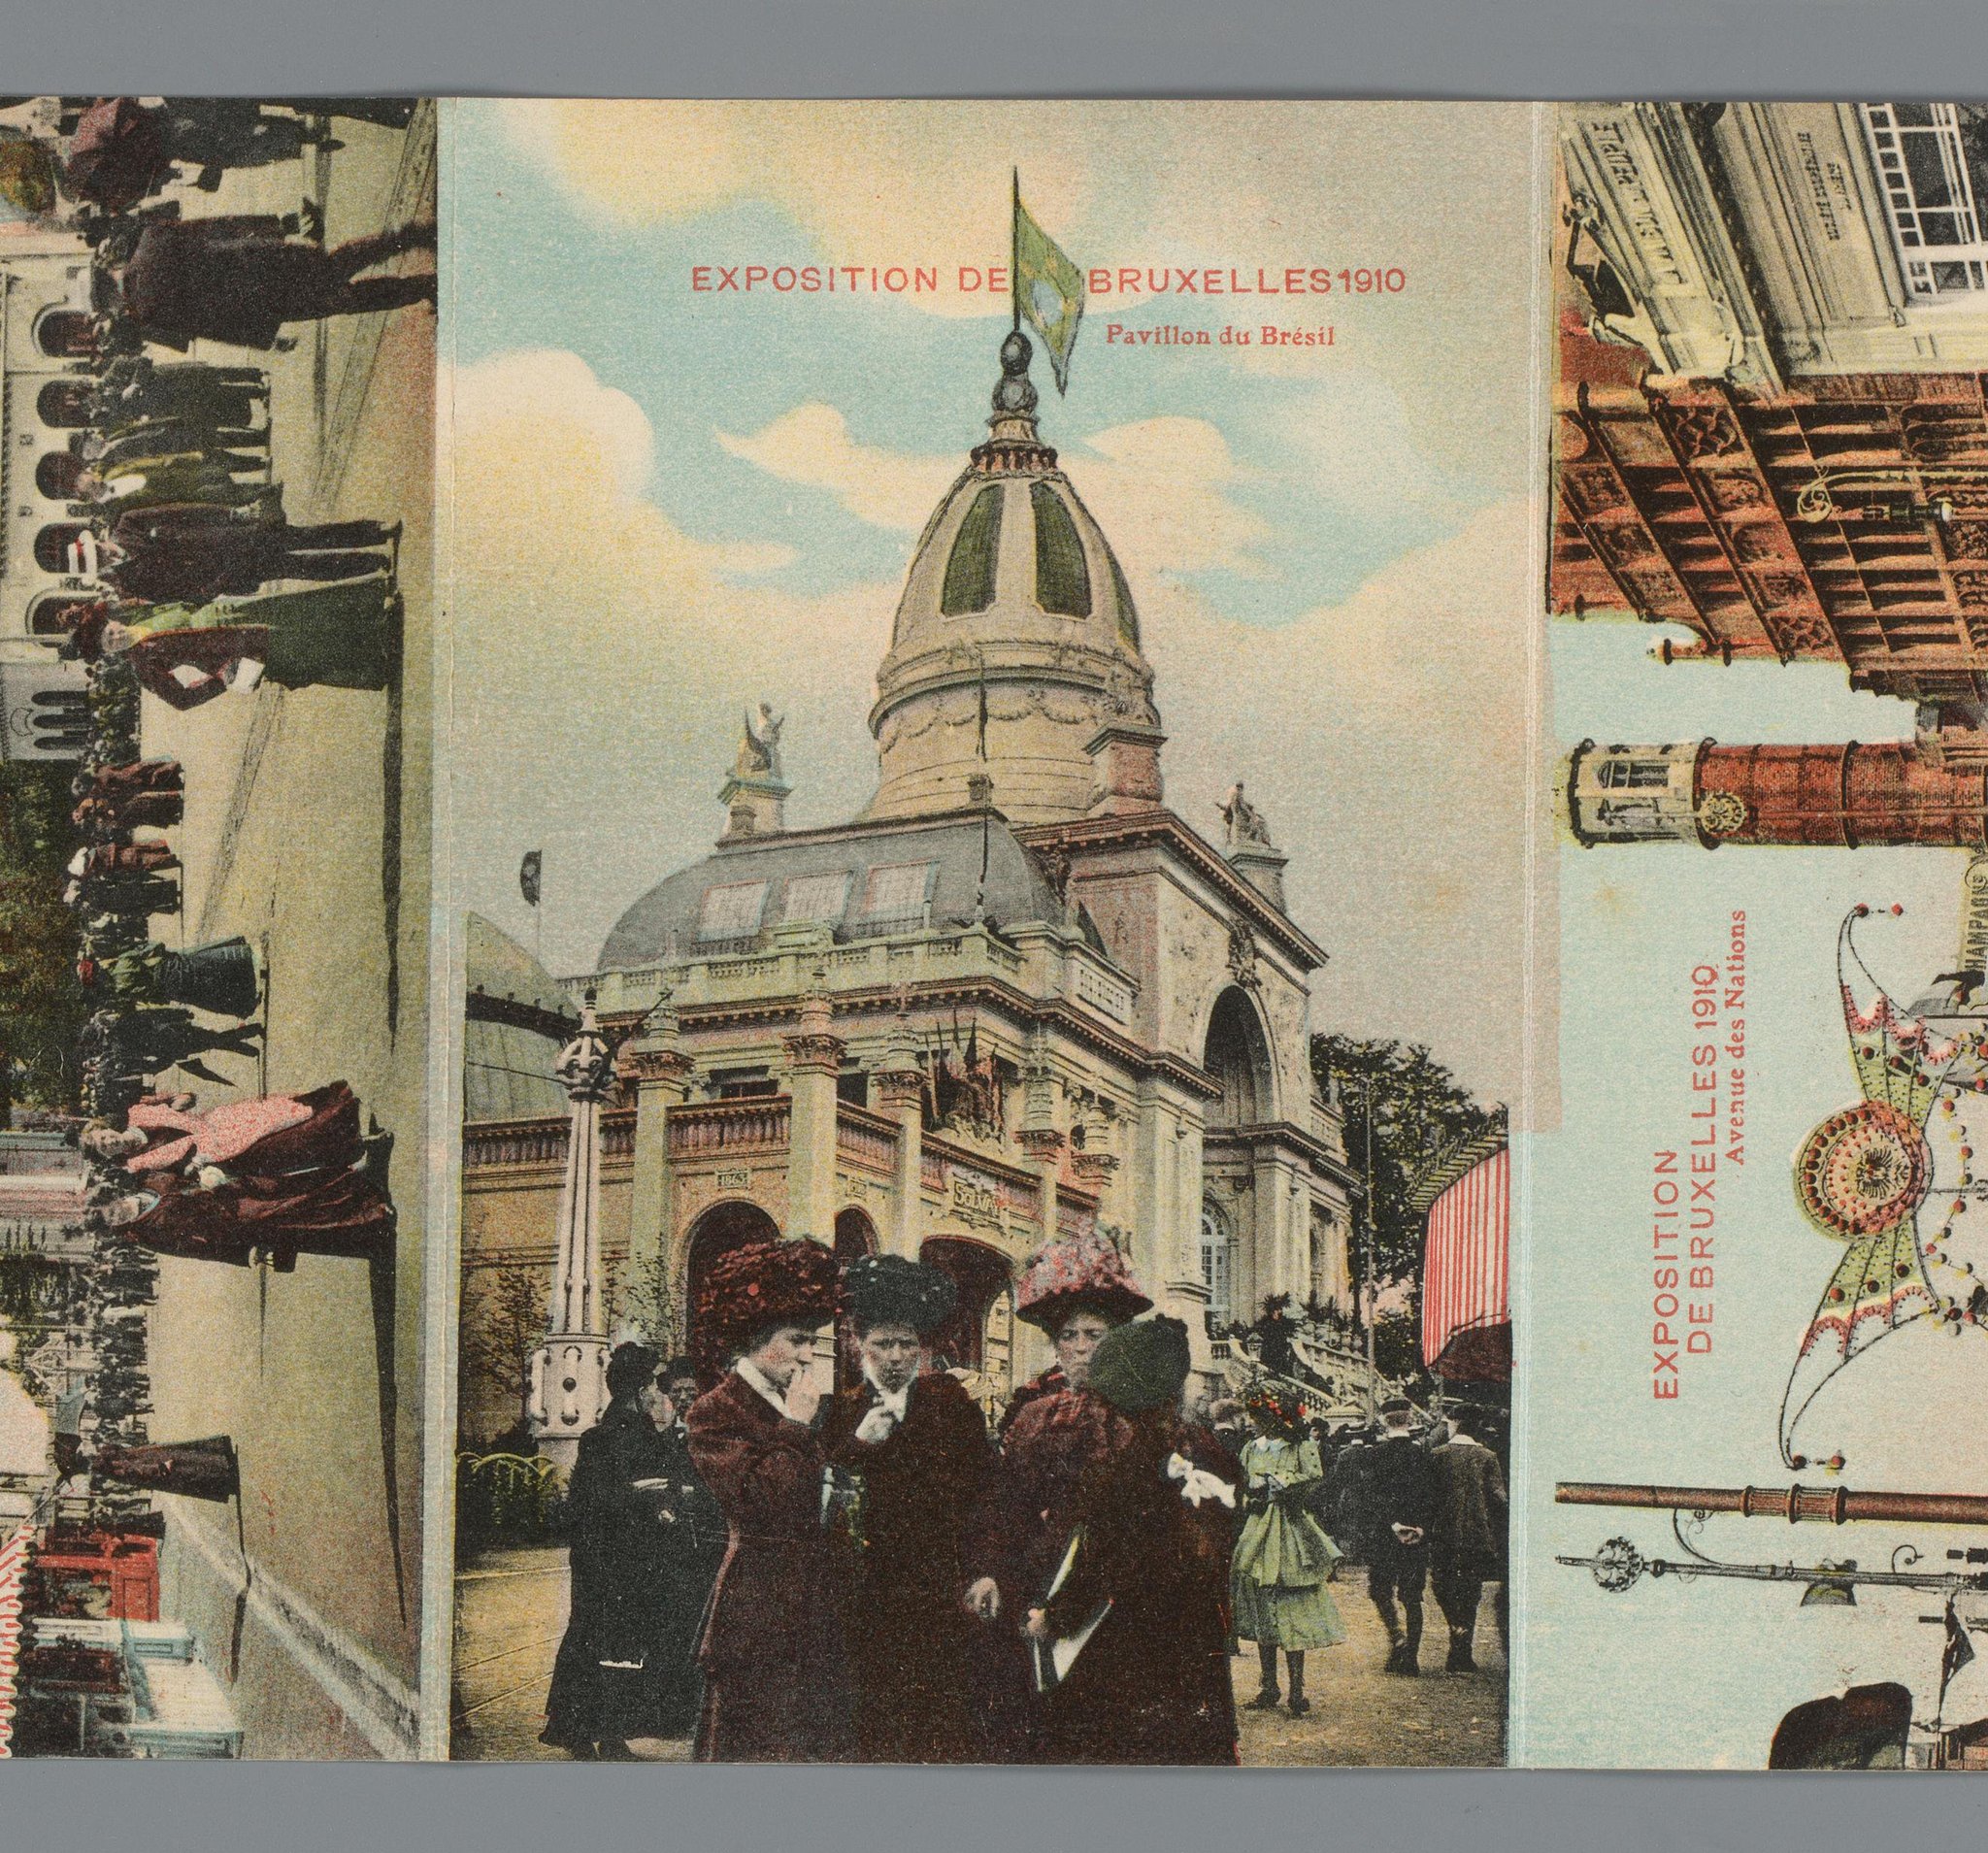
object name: ansichtkaart, prentbriefkaart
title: Pavillon du Brésil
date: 1910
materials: cardboard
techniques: photograph, lithograph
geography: brussels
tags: world fair, world exhibition, city-view, and landscape with man-made constructions (+ city(-scape) with figures, staffage), edifice, e.g.: public building, department store, brussels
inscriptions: date